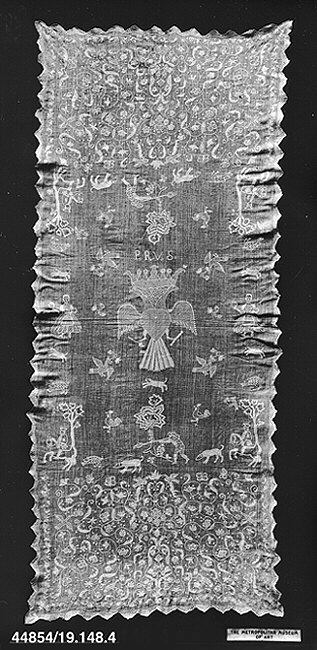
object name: scarf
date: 1801-1900